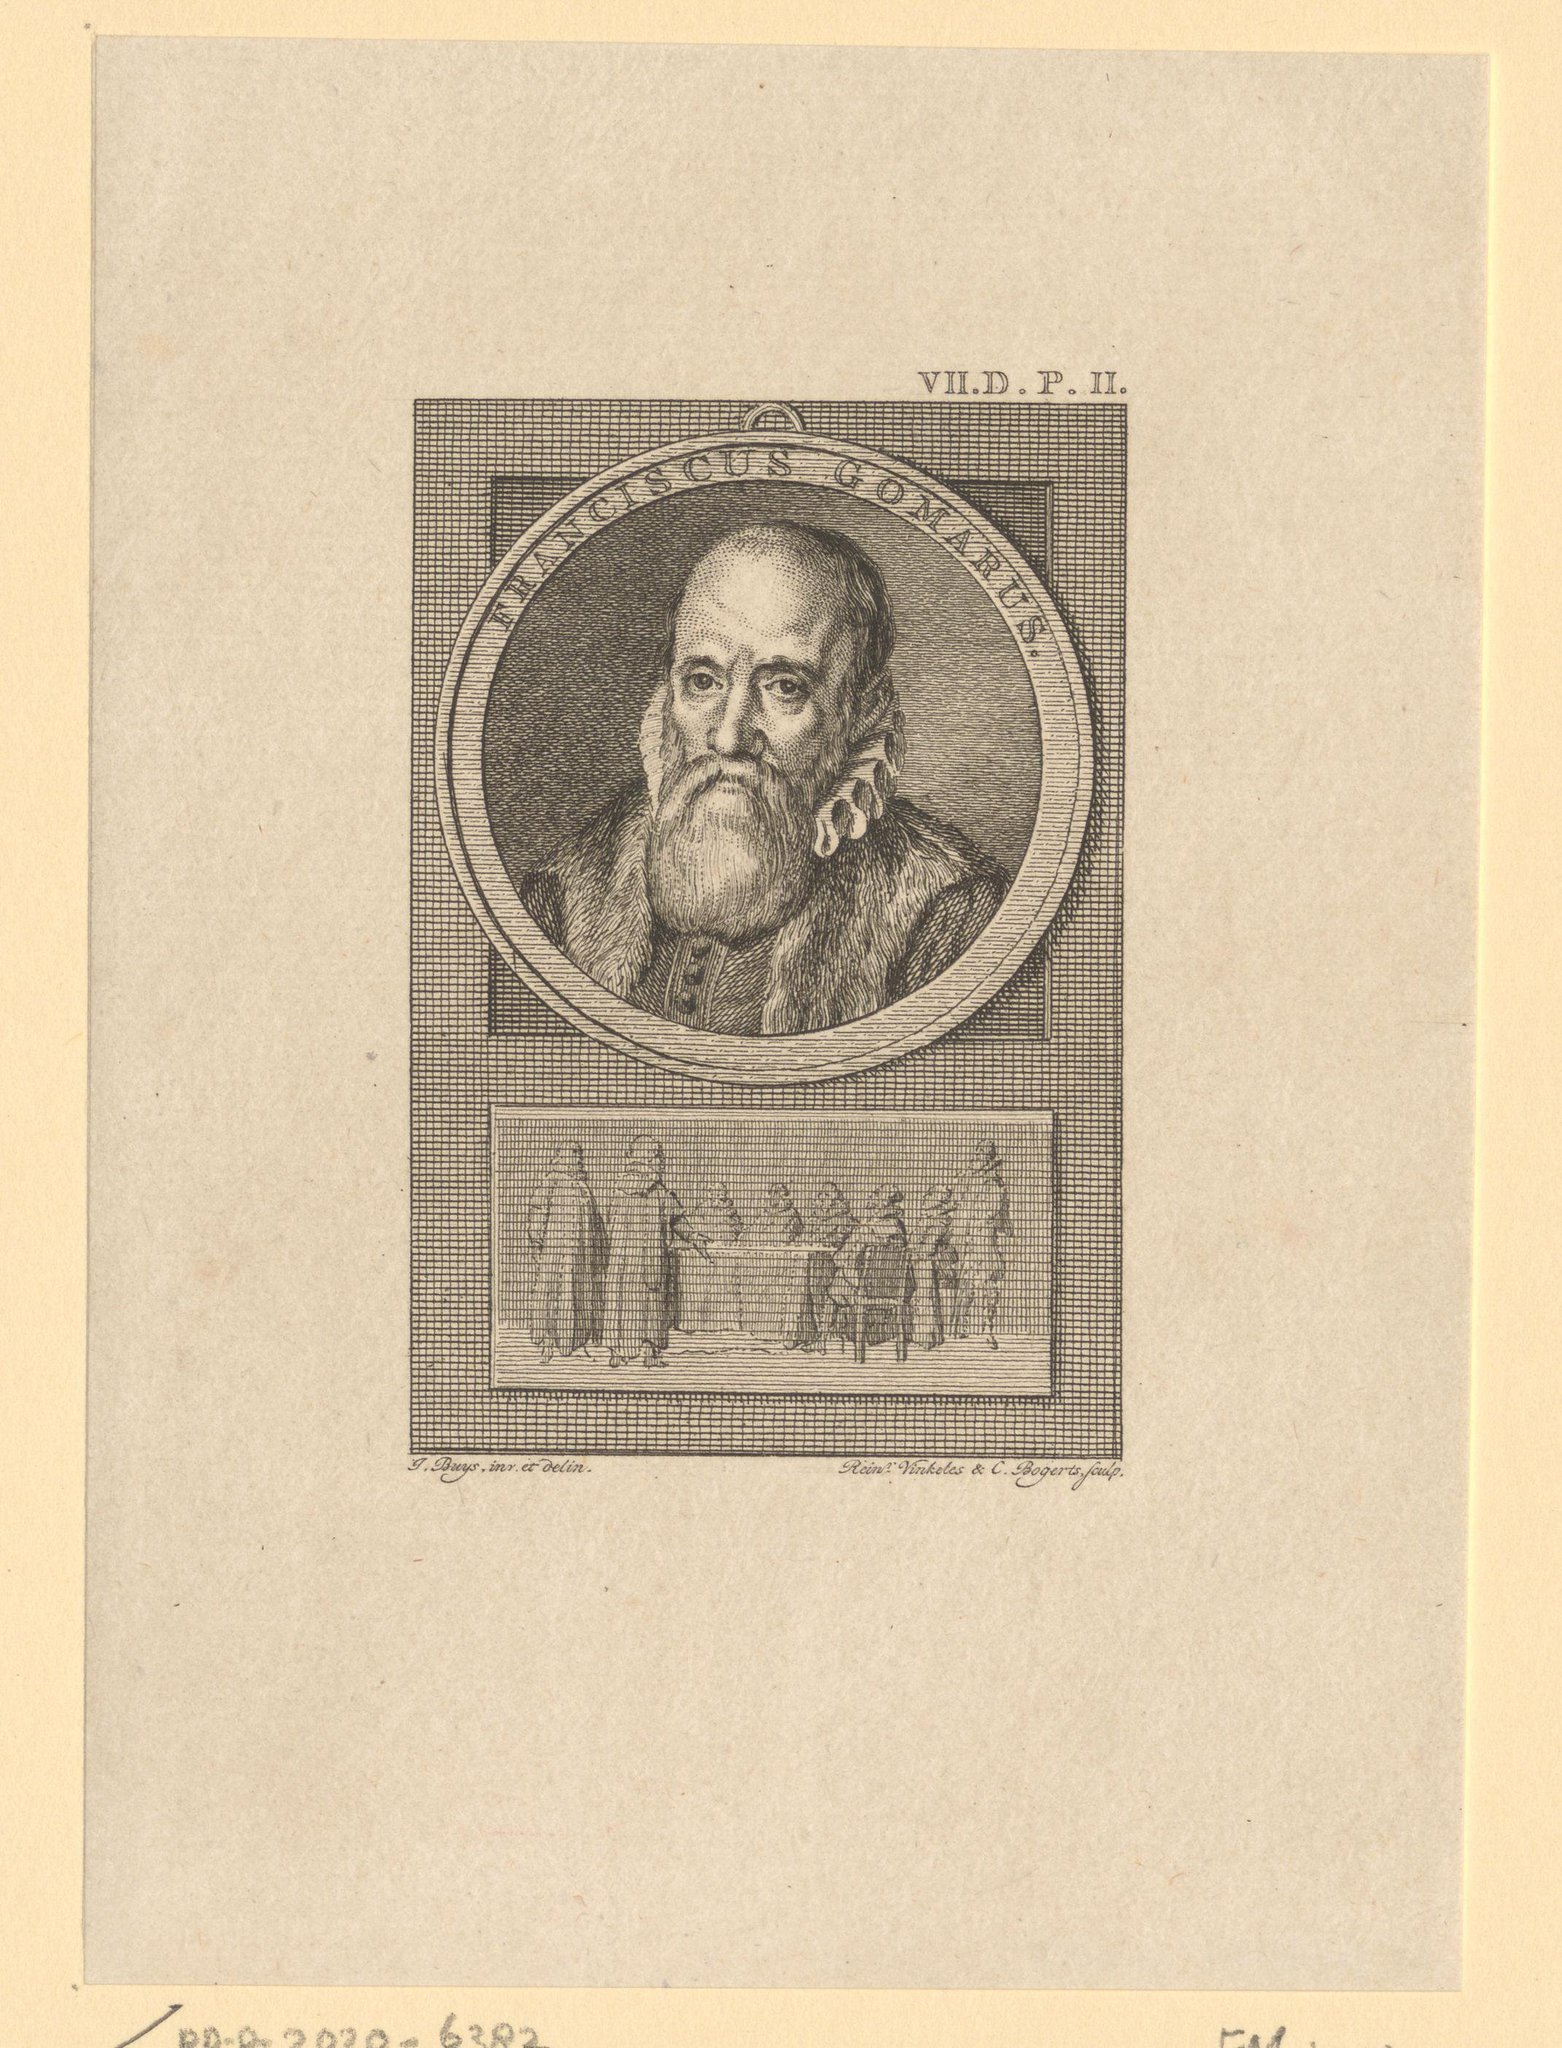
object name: print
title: Portret van Franciscus Gomarus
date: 1755-1795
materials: paper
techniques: engraving, etching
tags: bruges, theologian, historical persons, professor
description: Latere staat prent gebruikt in: Fokke, Jan. Geschiedenissen der Vereenigde Nederlanden voor de vaderlandsche jeugd (...). Amsterdam: Johannes Allart, [1783-1795], dl. 7.